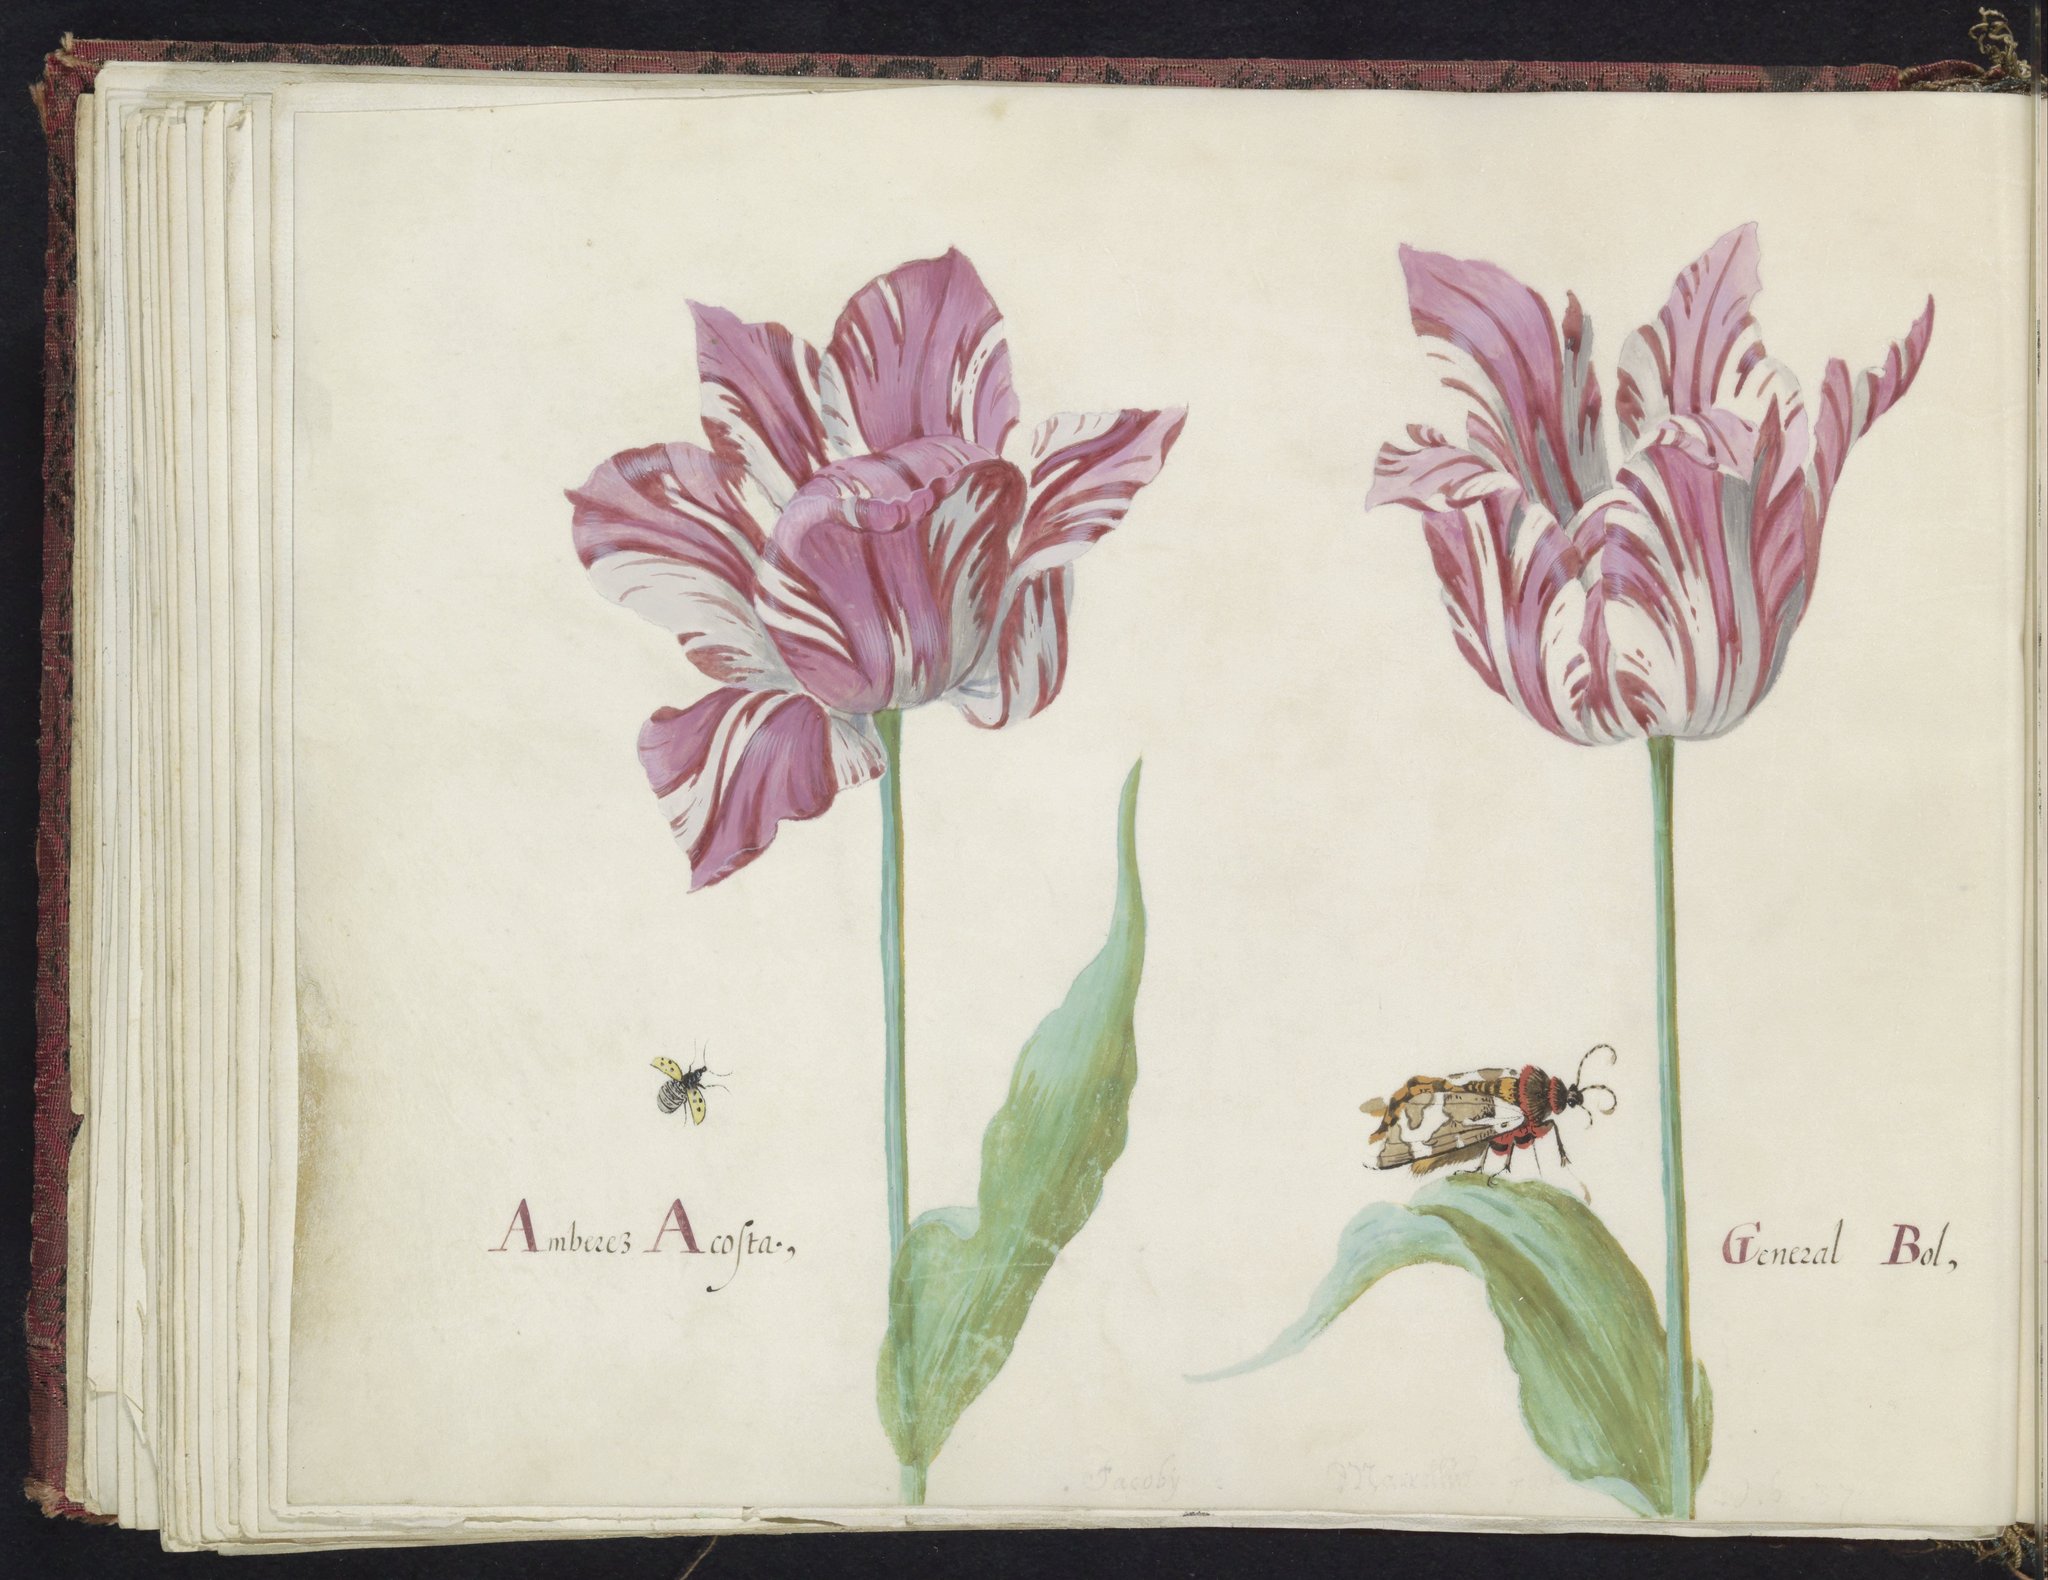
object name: drawing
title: Twee tulpen met vliegende kever en beervlinder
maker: jacob marrel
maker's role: draughtsman, painter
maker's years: 1614-1681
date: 1637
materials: paint, parchment, pencil, watercolor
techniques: brush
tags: insects: butterfly, flowers: tulip, insects: beetle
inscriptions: date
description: De tekening maakt deel uit van een album.